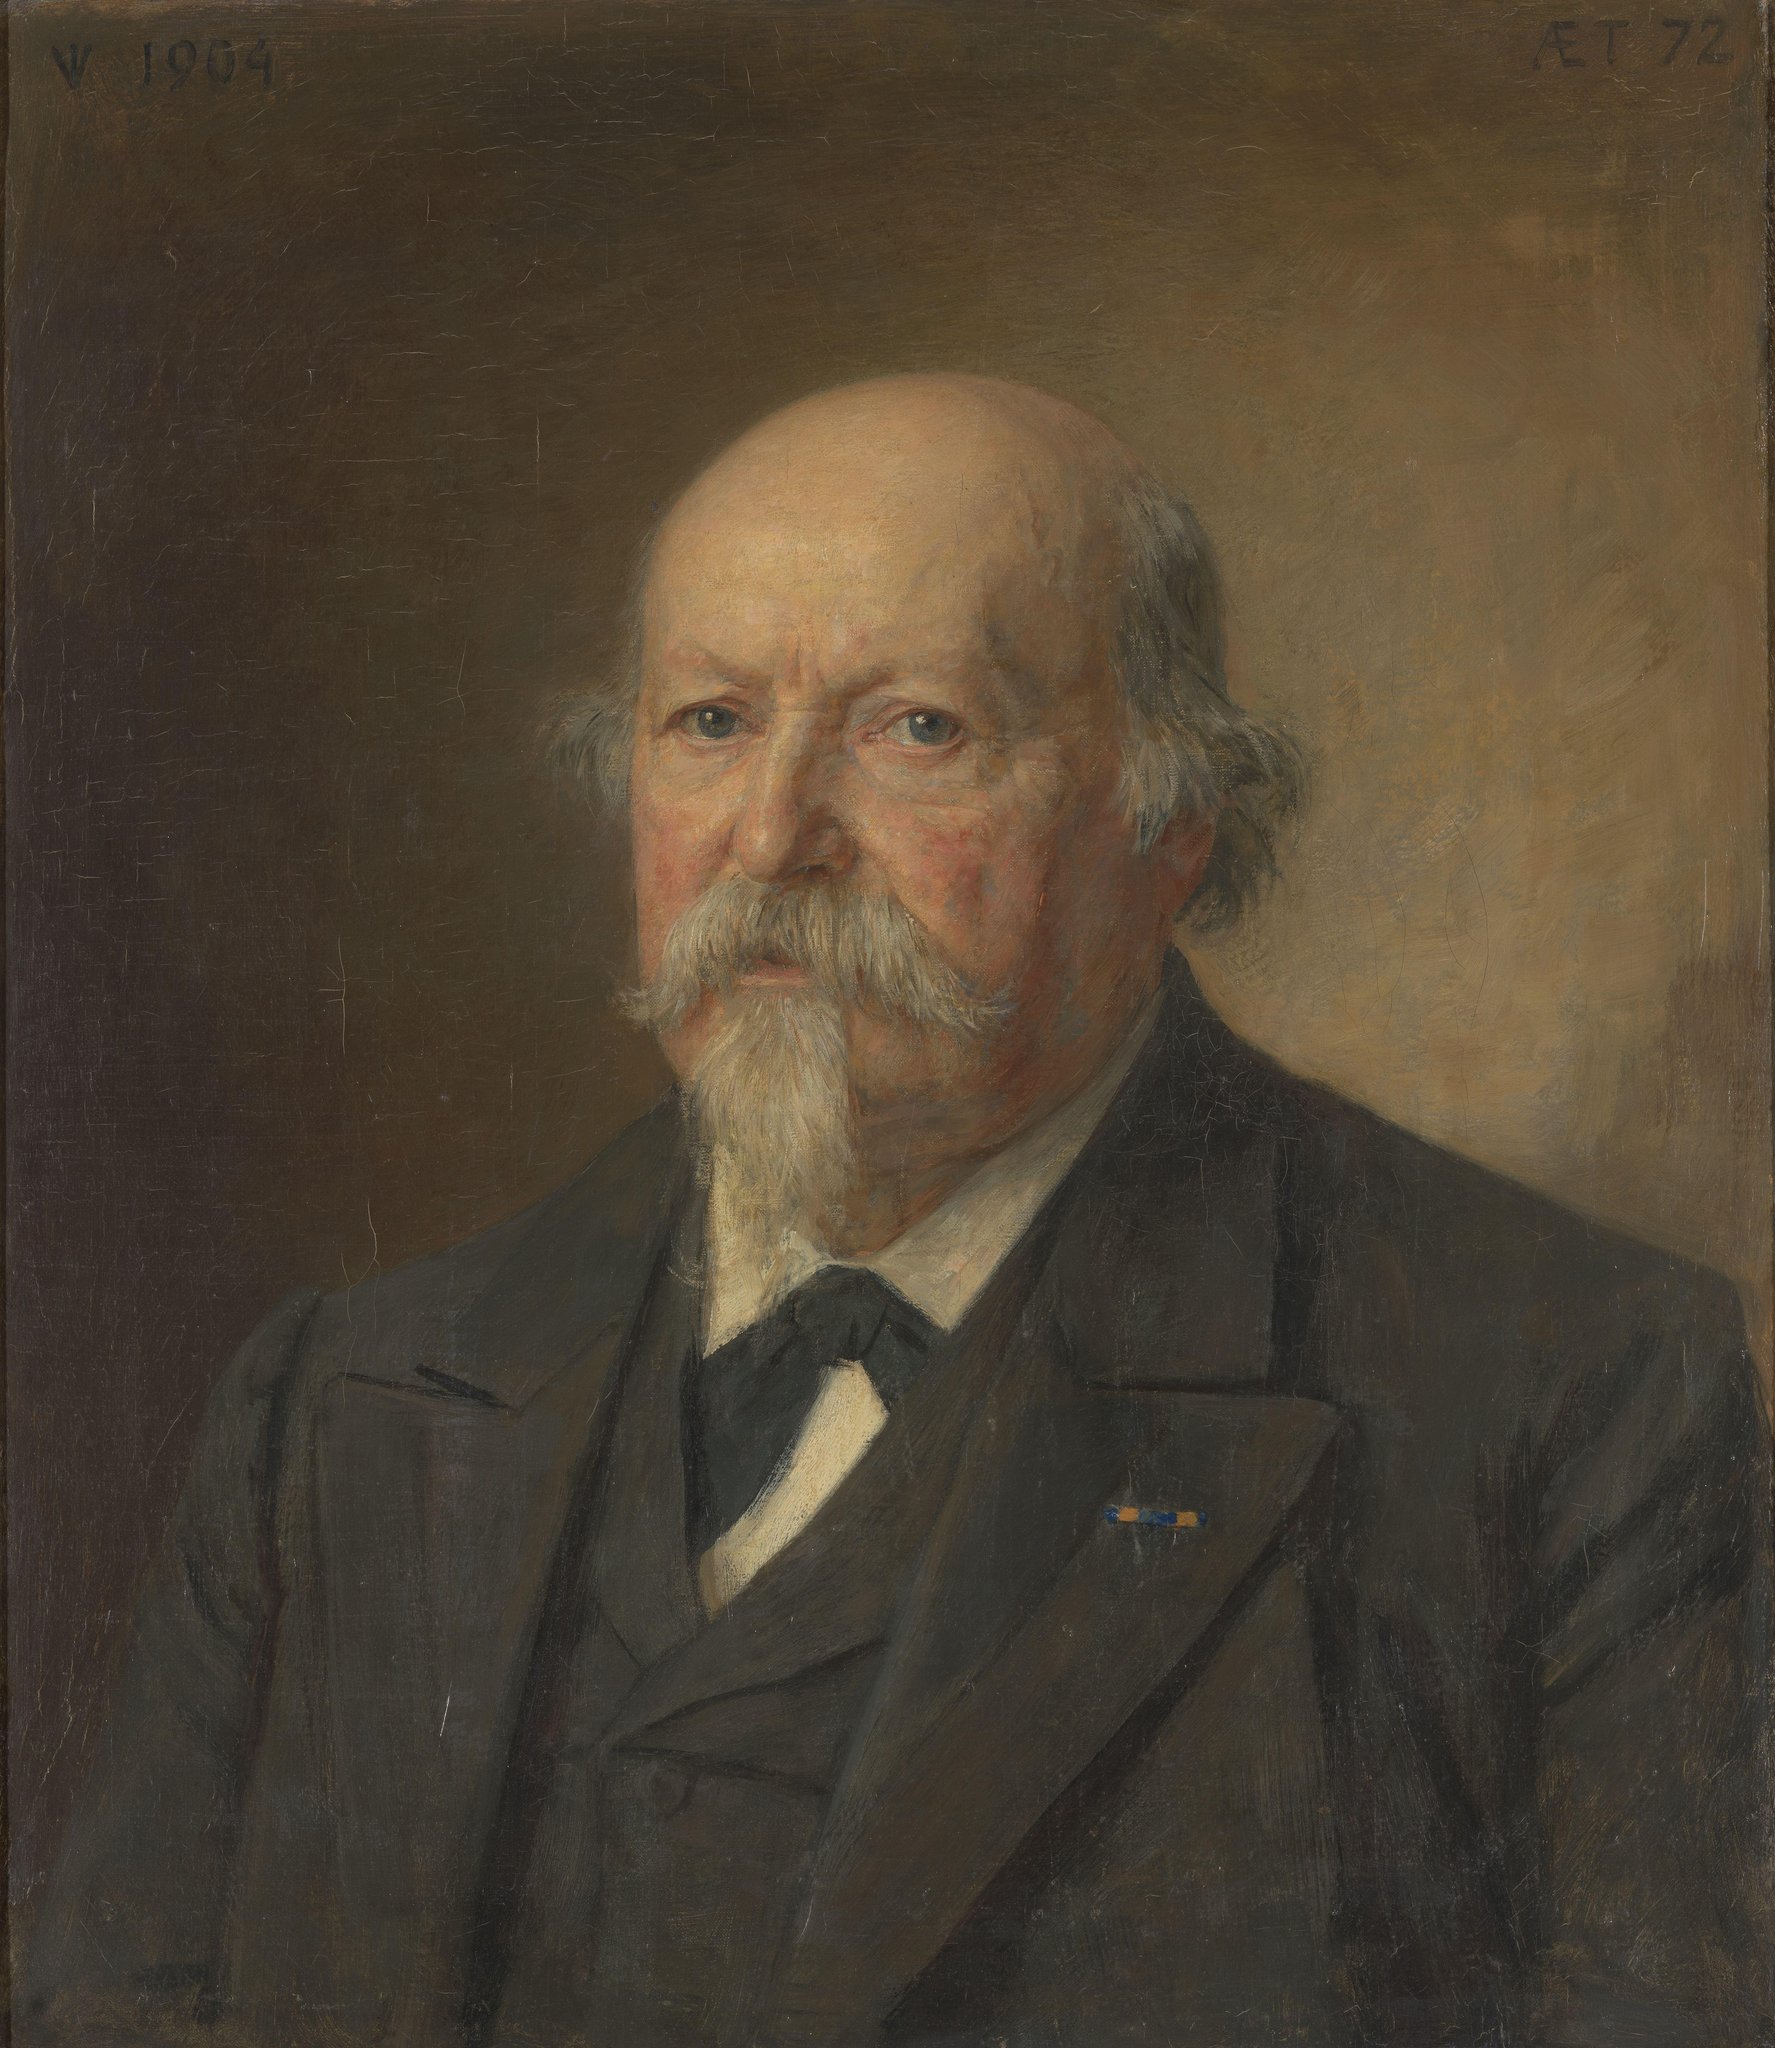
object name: painting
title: Johan Philip van der Kellen (1831-1906). Directeur van het Rijksprentenkabinet (1876-96)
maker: jan veth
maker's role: designer, draughtsman, painter, print maker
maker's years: 1864-1925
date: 1904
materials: canvas, oil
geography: netherlands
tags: print room, utrecht, print maker, draughtsman, johan philip van der kellen, museum personnel, historical persons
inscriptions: signature and date: ‘JV 1904 AET 72’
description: Portret van Johan Philip van der Kellen (1831-1906), directeur van het Rijksprentenkabinet (1876-96). Buste naar links.